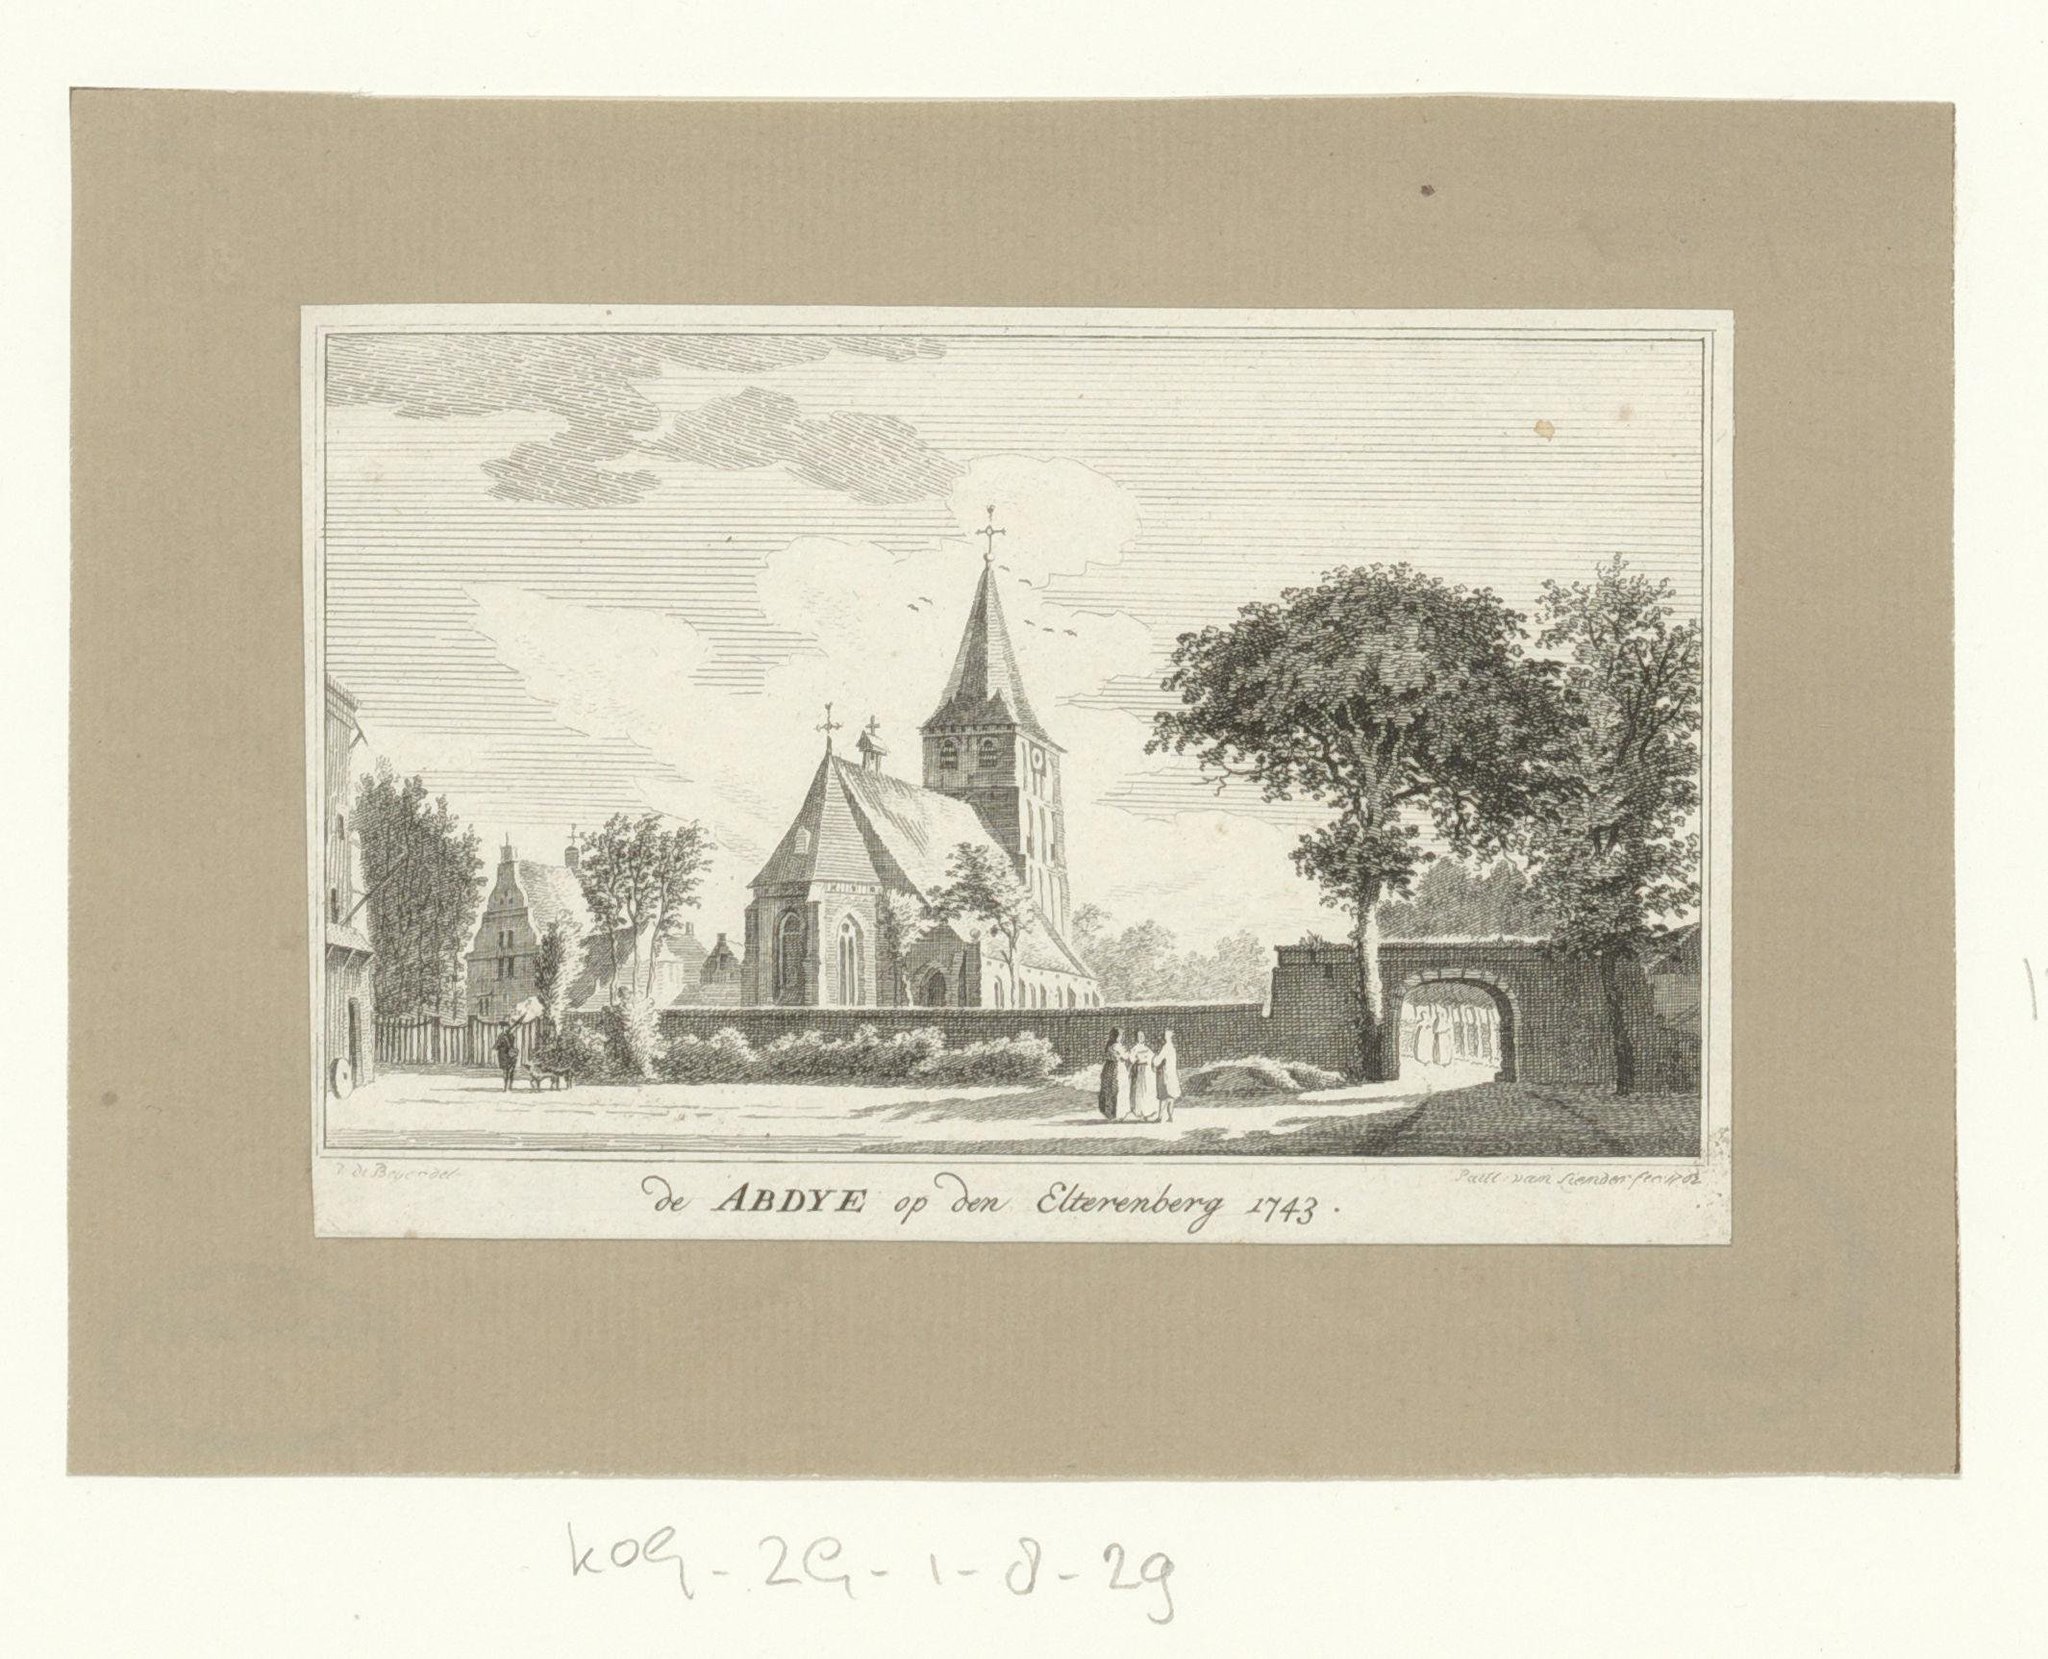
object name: print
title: de Abdye op den Elterenberg 1743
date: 1762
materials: paper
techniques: etching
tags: abbey, monastery, convent ~ roman catholic church, village, church (exterior)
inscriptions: collector's mark, collector's mark: Lugt 1641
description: Gezicht op de Vitusabdij en Sint-Vituskerk op de Eltenberg, in het dorp Hoog-Elten, omstreeks 1743. Helft van een plaat met twee voorstellingen. De prent maakt deel uit van een 100-delige serie met gezichten op dorpen en steden te Kleef. Onderwerpsrubrieken binnen de Atlas Zeden en Gewoonten: Kerk en kerkwezen & Armwezen en liefdadige instellingen; Kerkgebouwen elders. A-E.